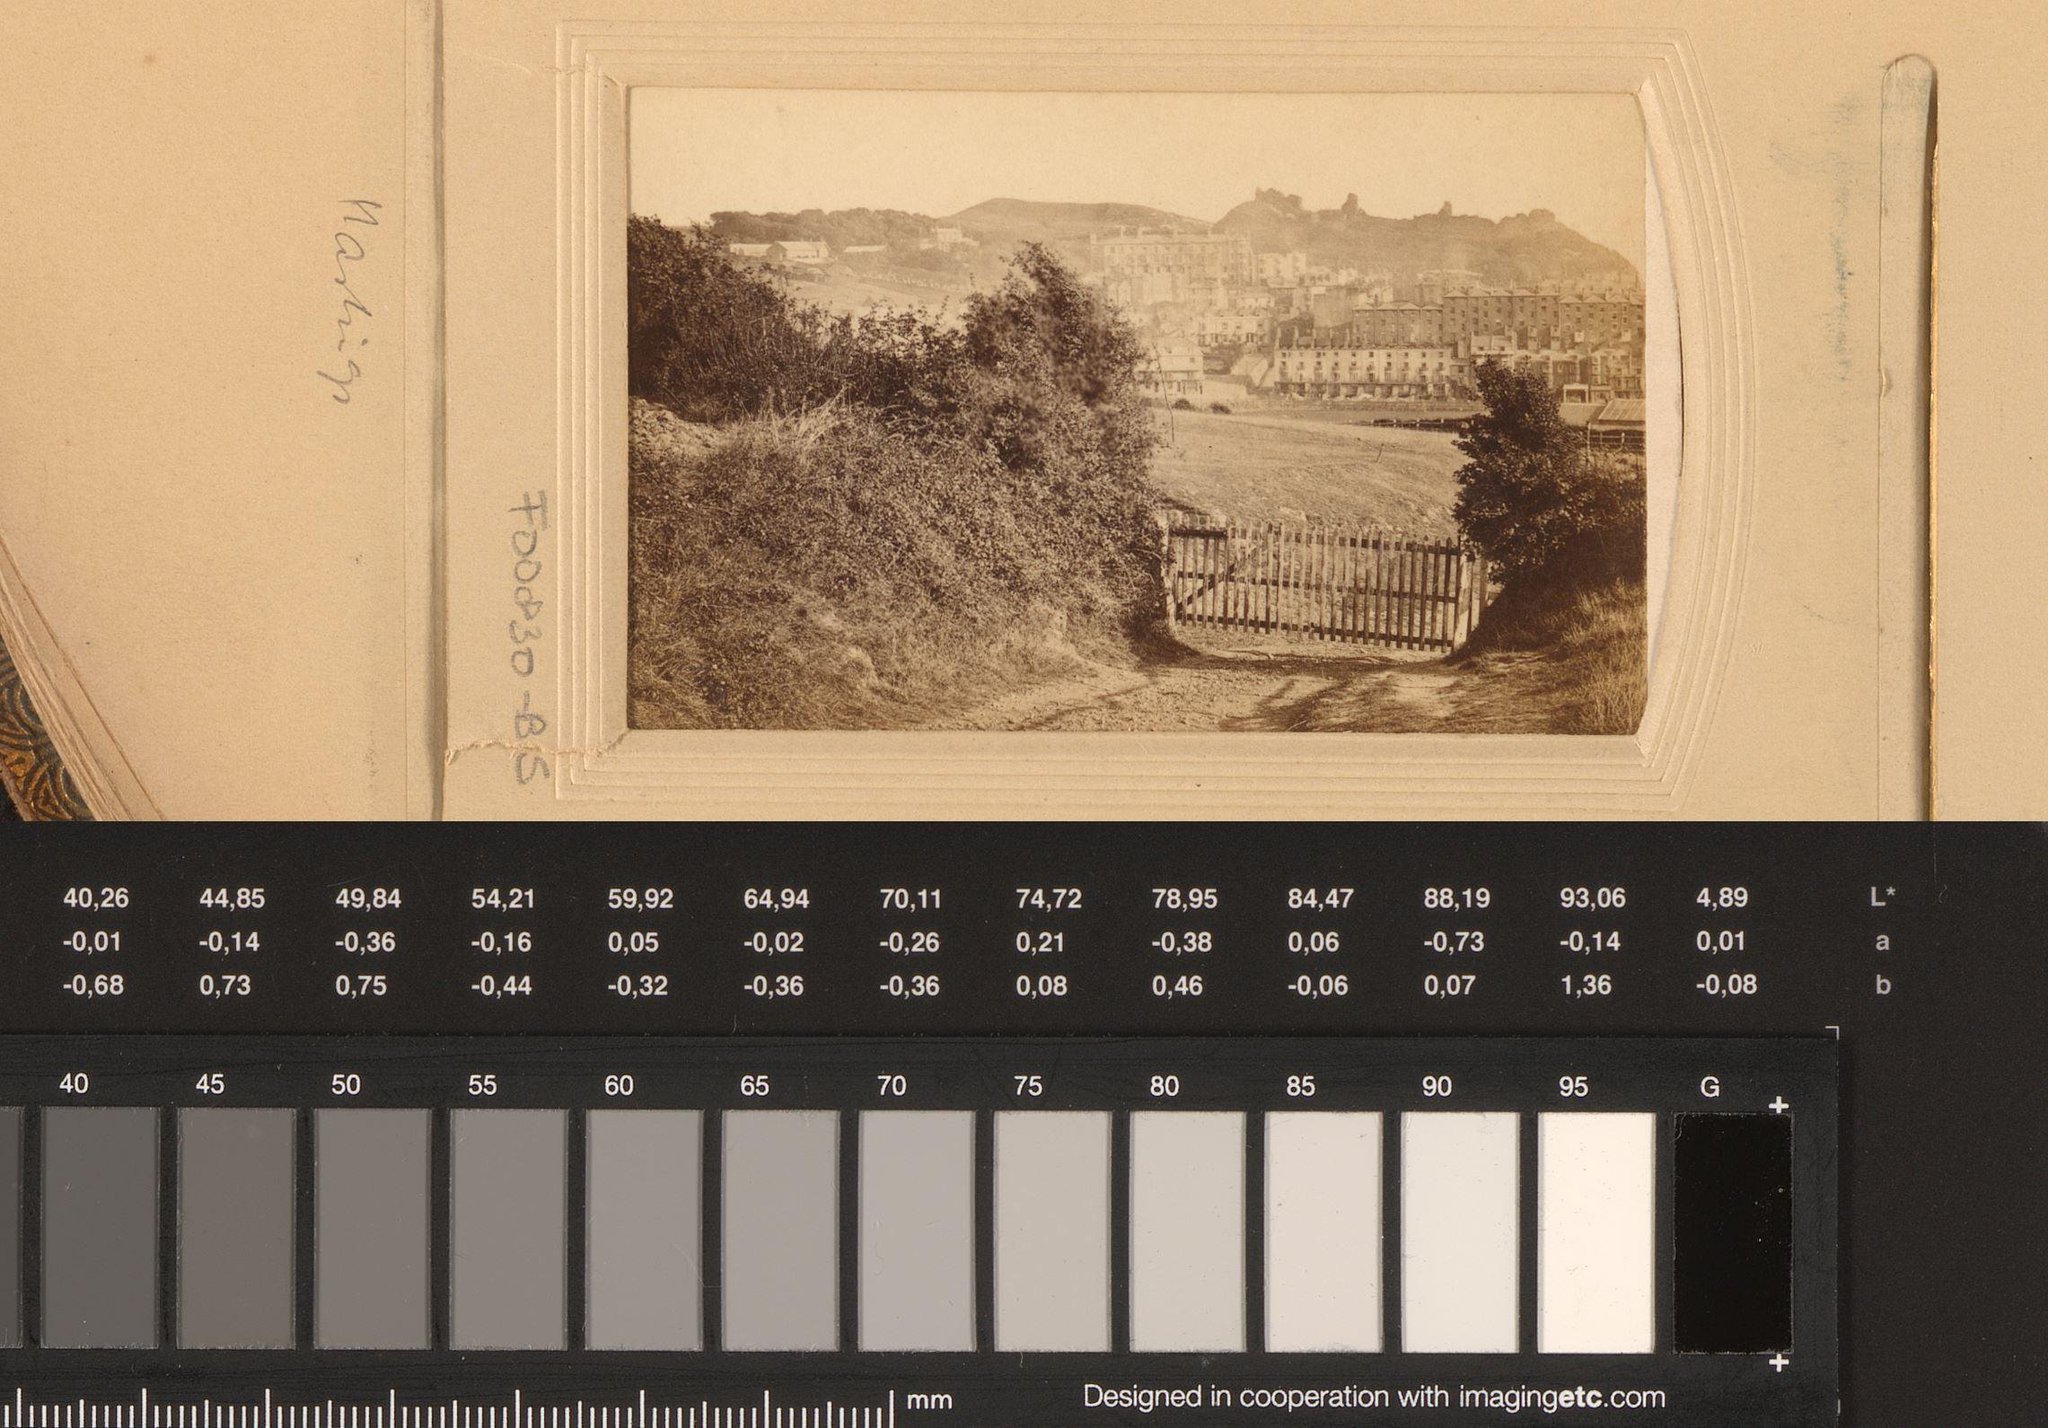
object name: photograph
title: Gezicht op Hastings met de ruïnes van Hastings Castle, gezien vanaf het station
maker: frances sutherland mann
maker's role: fotograaf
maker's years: 1867-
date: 1870-1900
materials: cardboard, photographic support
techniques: albumen print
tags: city-view in general; 'veduta', ruin of a dwelling, house, castle, etc.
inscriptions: inscription: ‘F.S. Mann/ Photographic/Artist/13/ Wellington/ Place/ Hastings’, annotation: ‘Hastings from the/ Railway Station/ Castle ruins in distance’